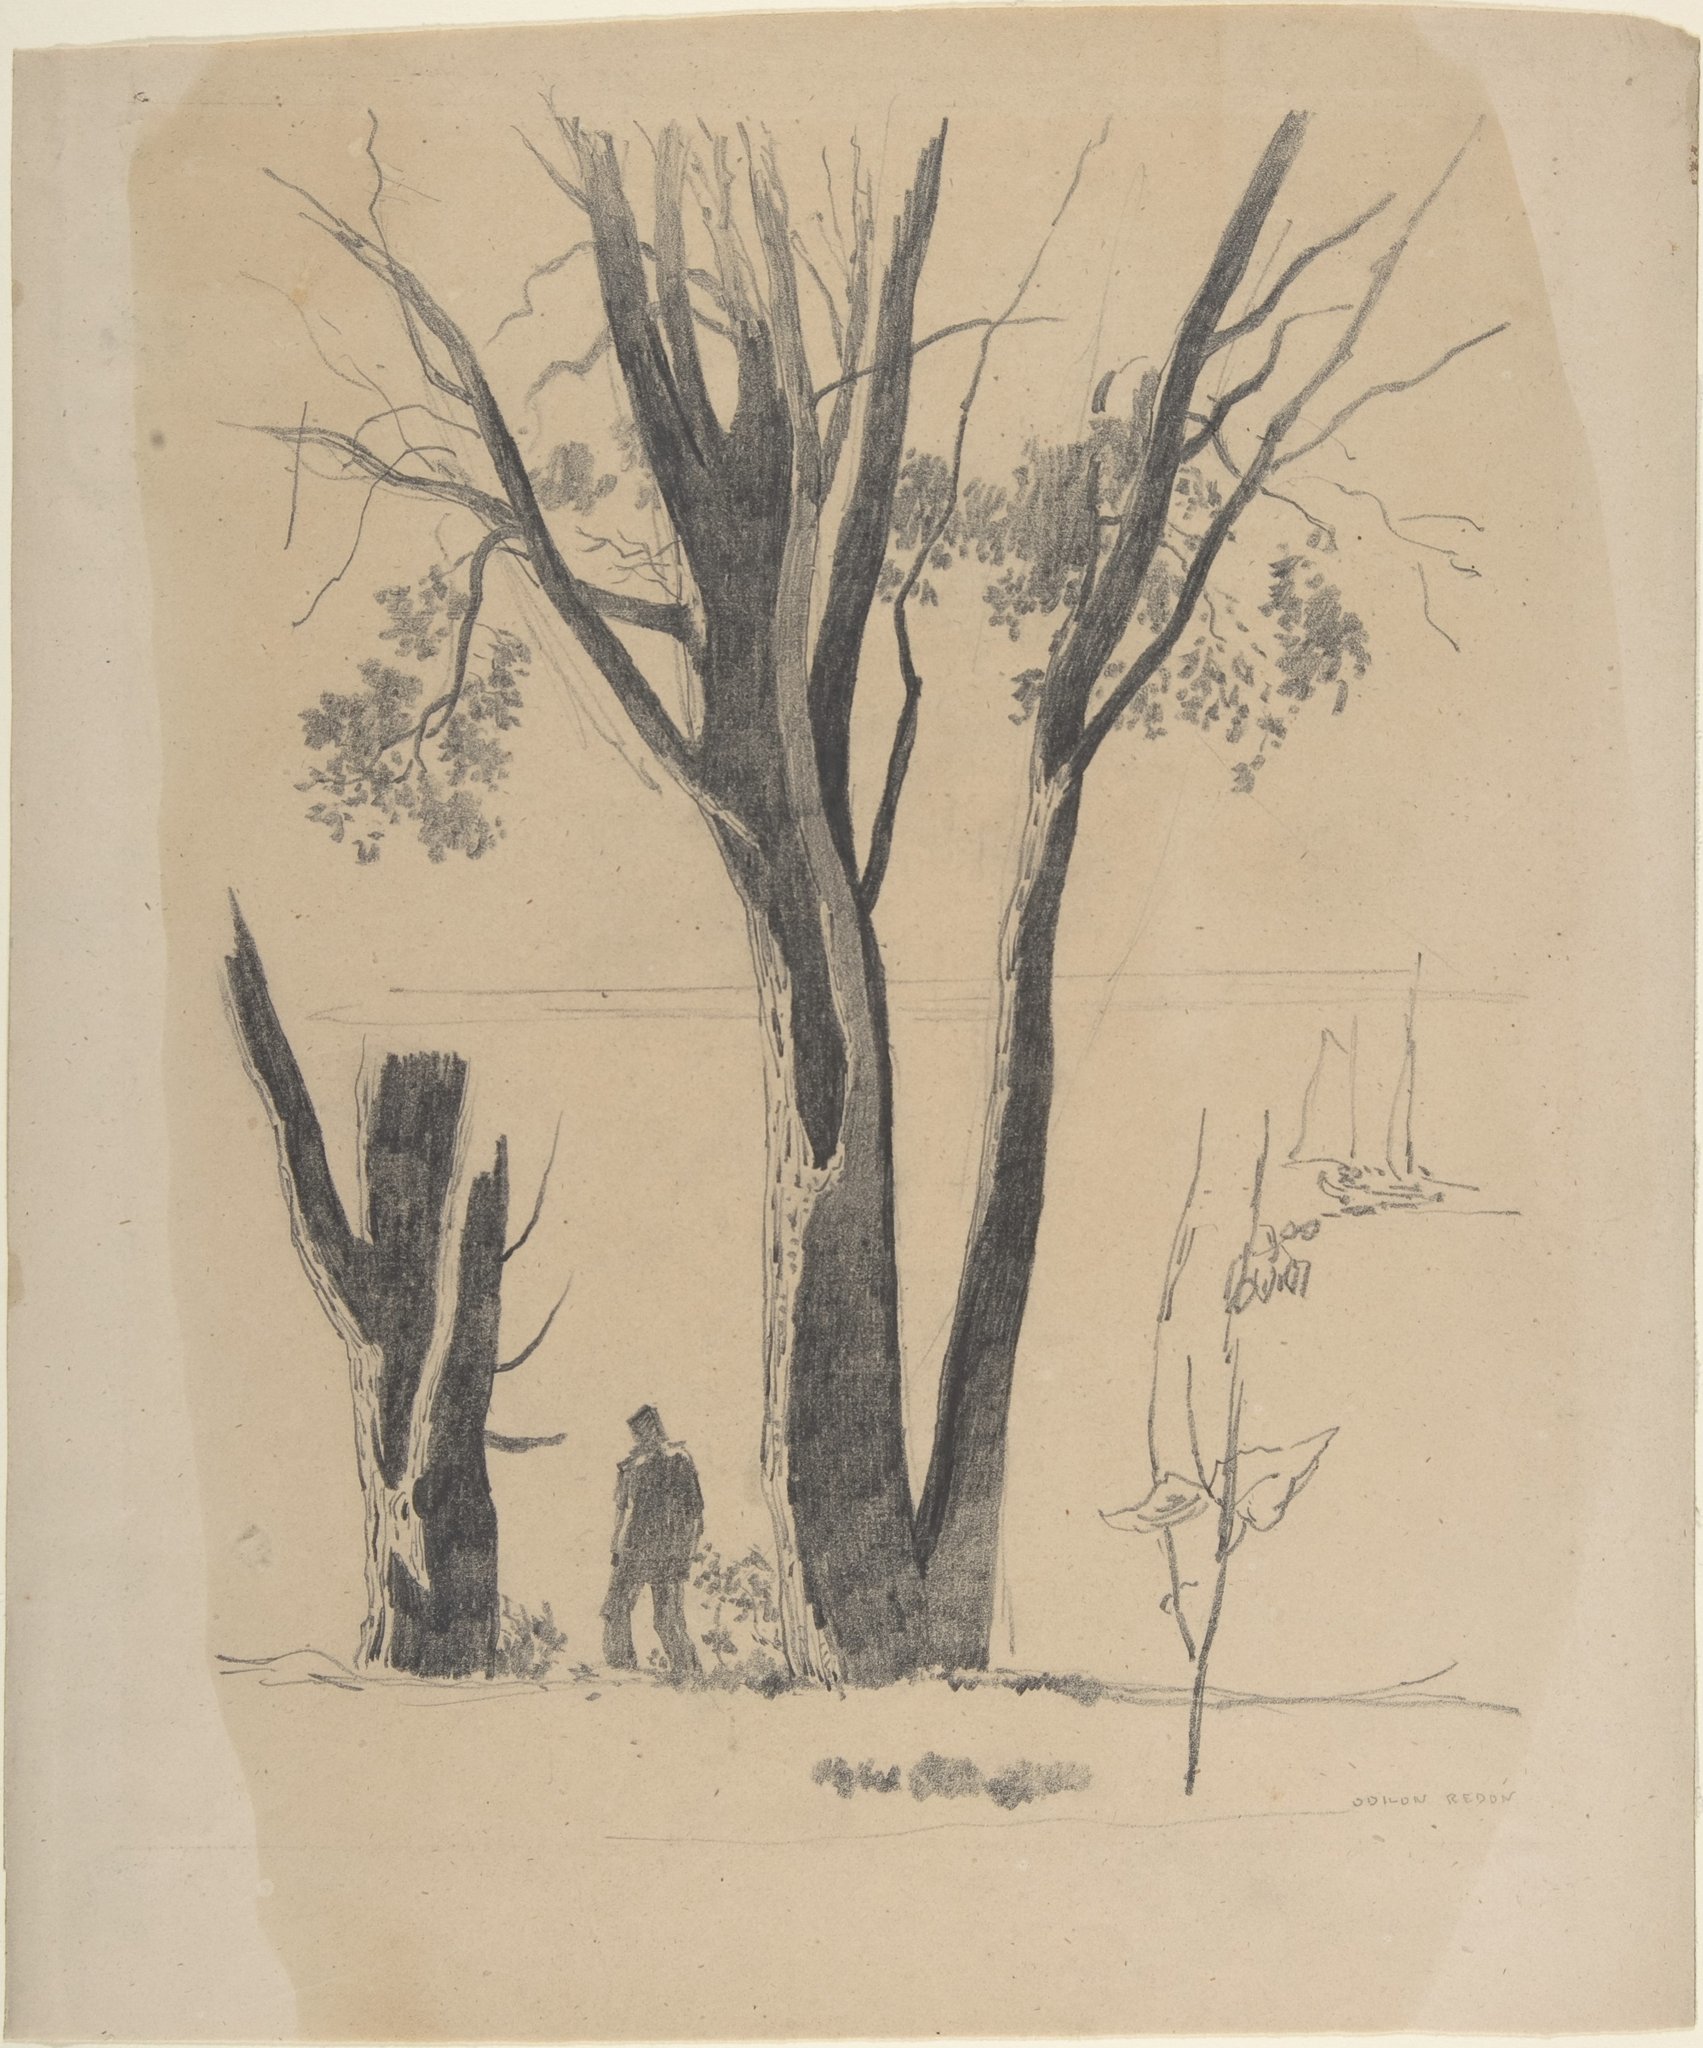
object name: drawing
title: Study of Man between Trees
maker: odilon redon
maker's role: artist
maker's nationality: french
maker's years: 1840-1916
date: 1860-1880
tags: men,trees